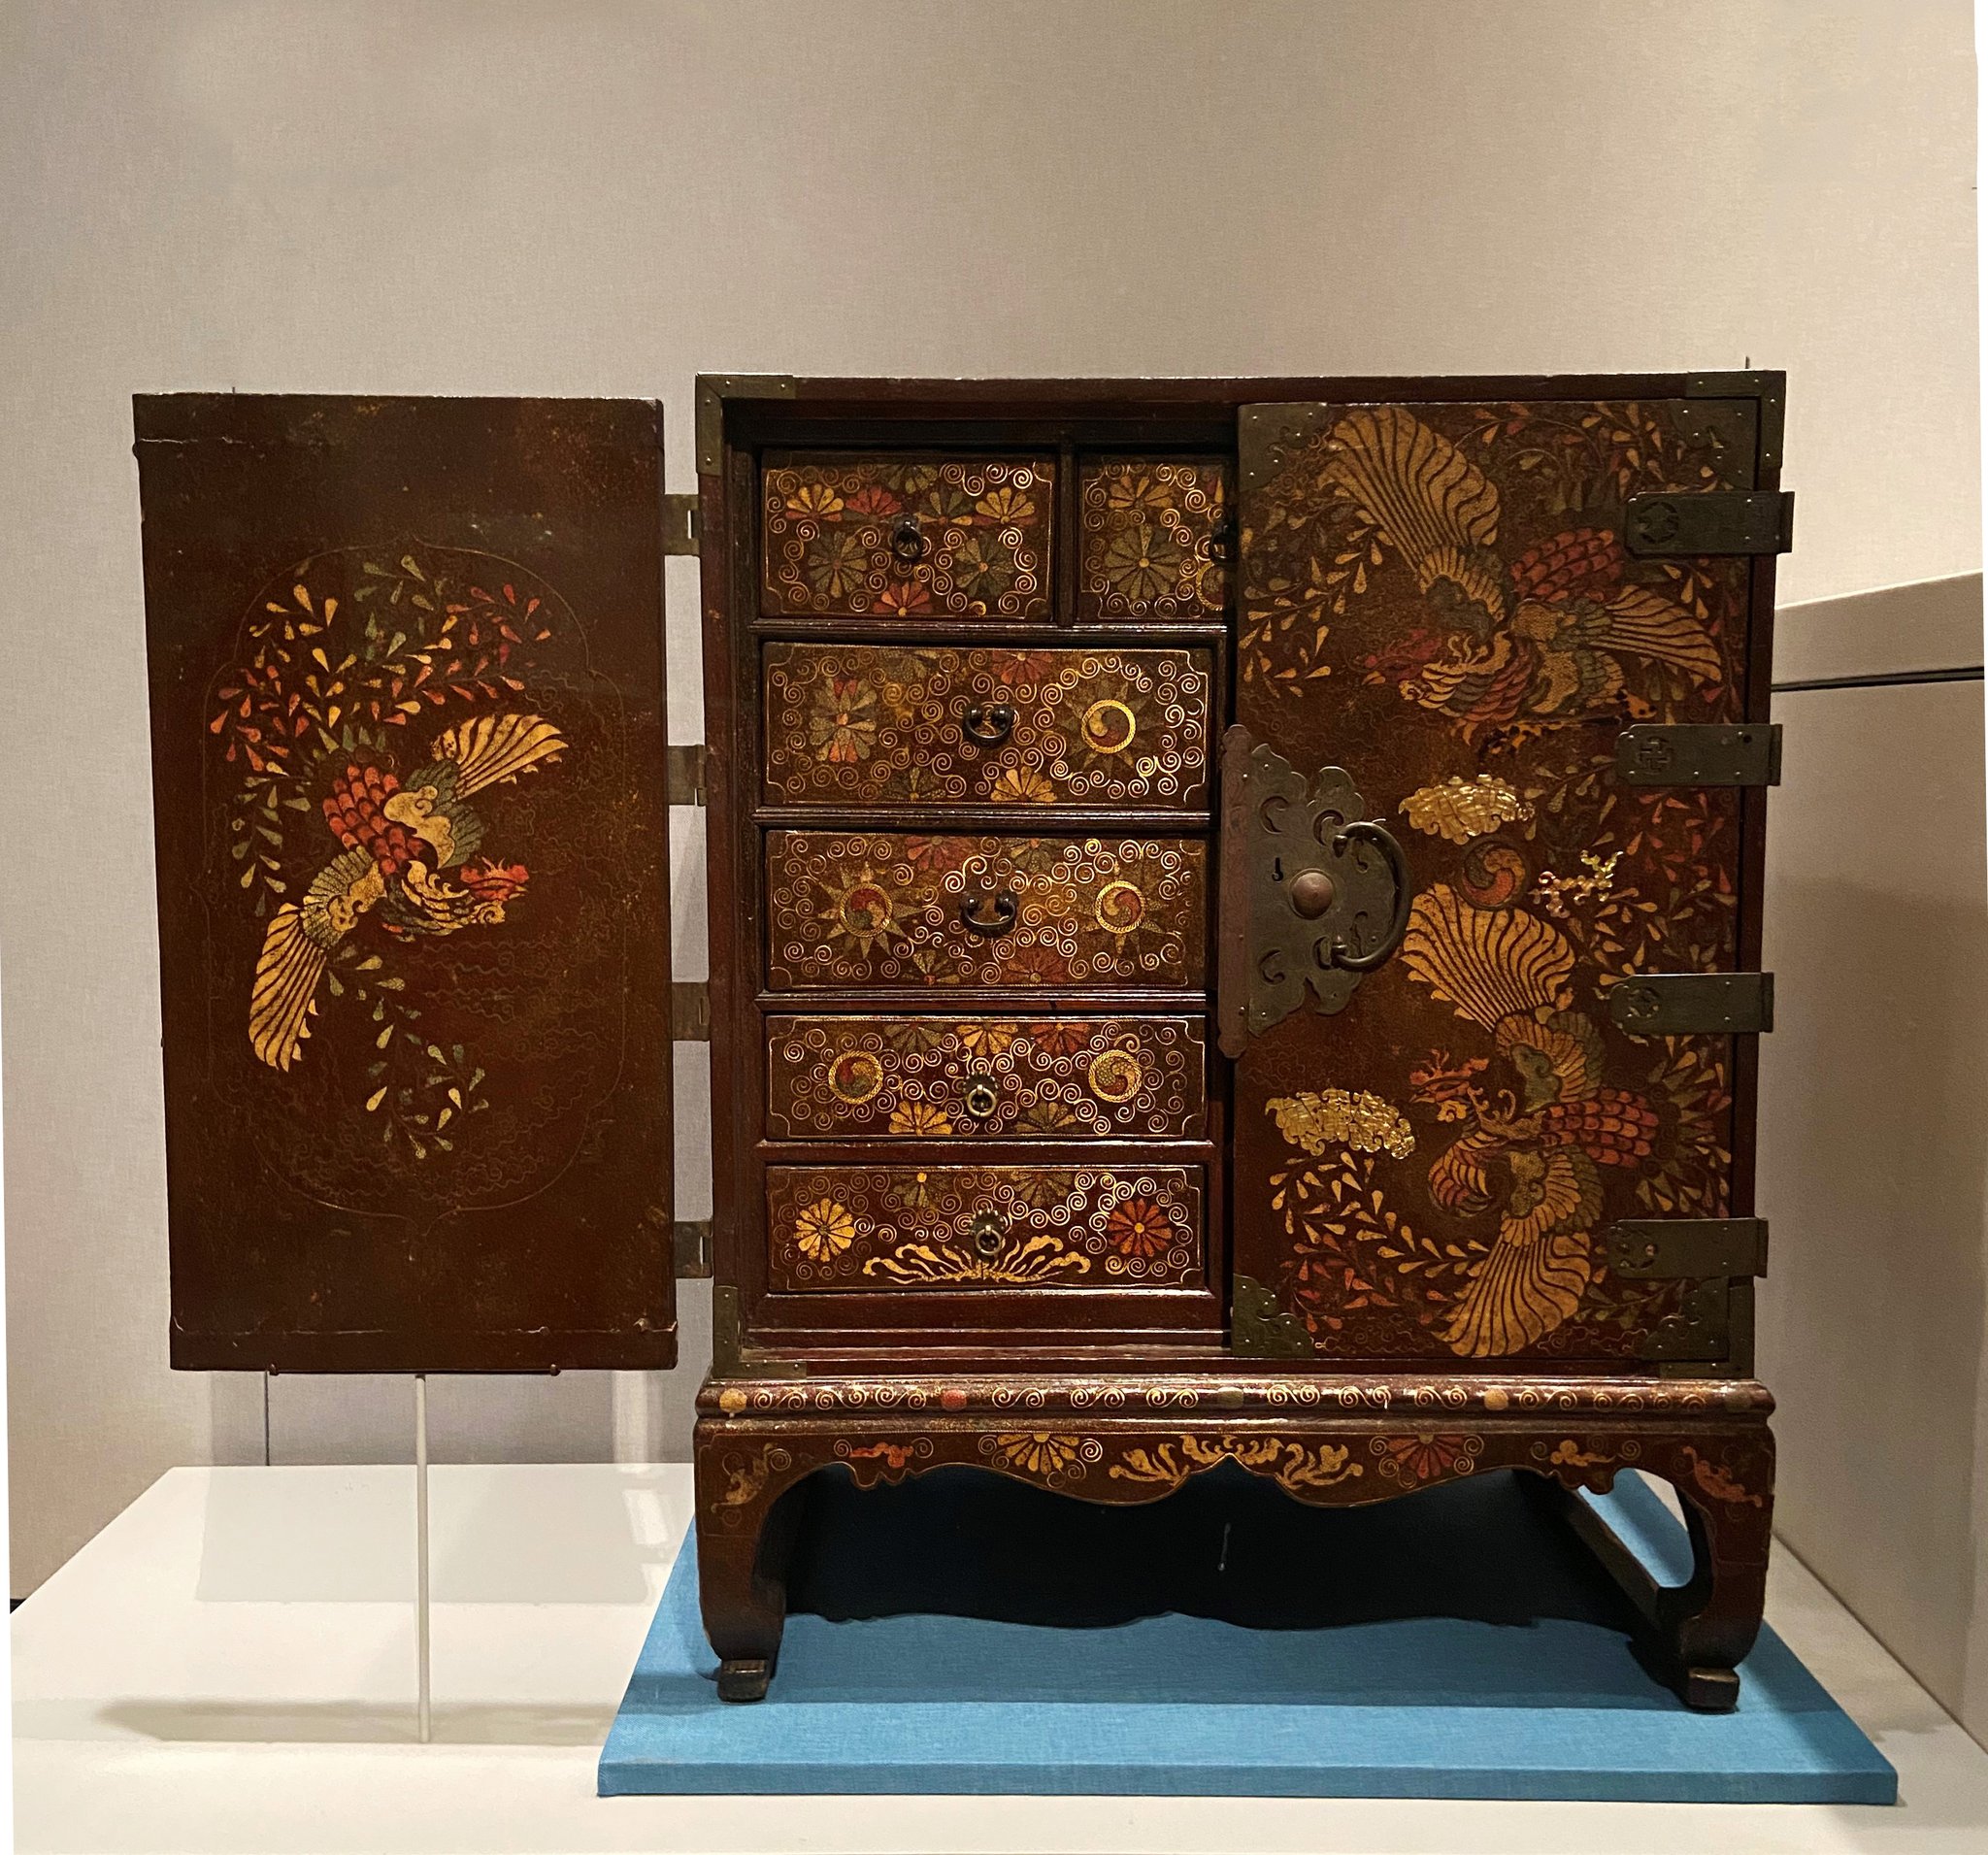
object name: chest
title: Chest decorated with phoenixes, colored roundels (taegeuk), and flowers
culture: korean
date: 1901-1933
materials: brass, mother of pearl, skin, shell, metal, wood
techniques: inlay, lacquer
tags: phoenix